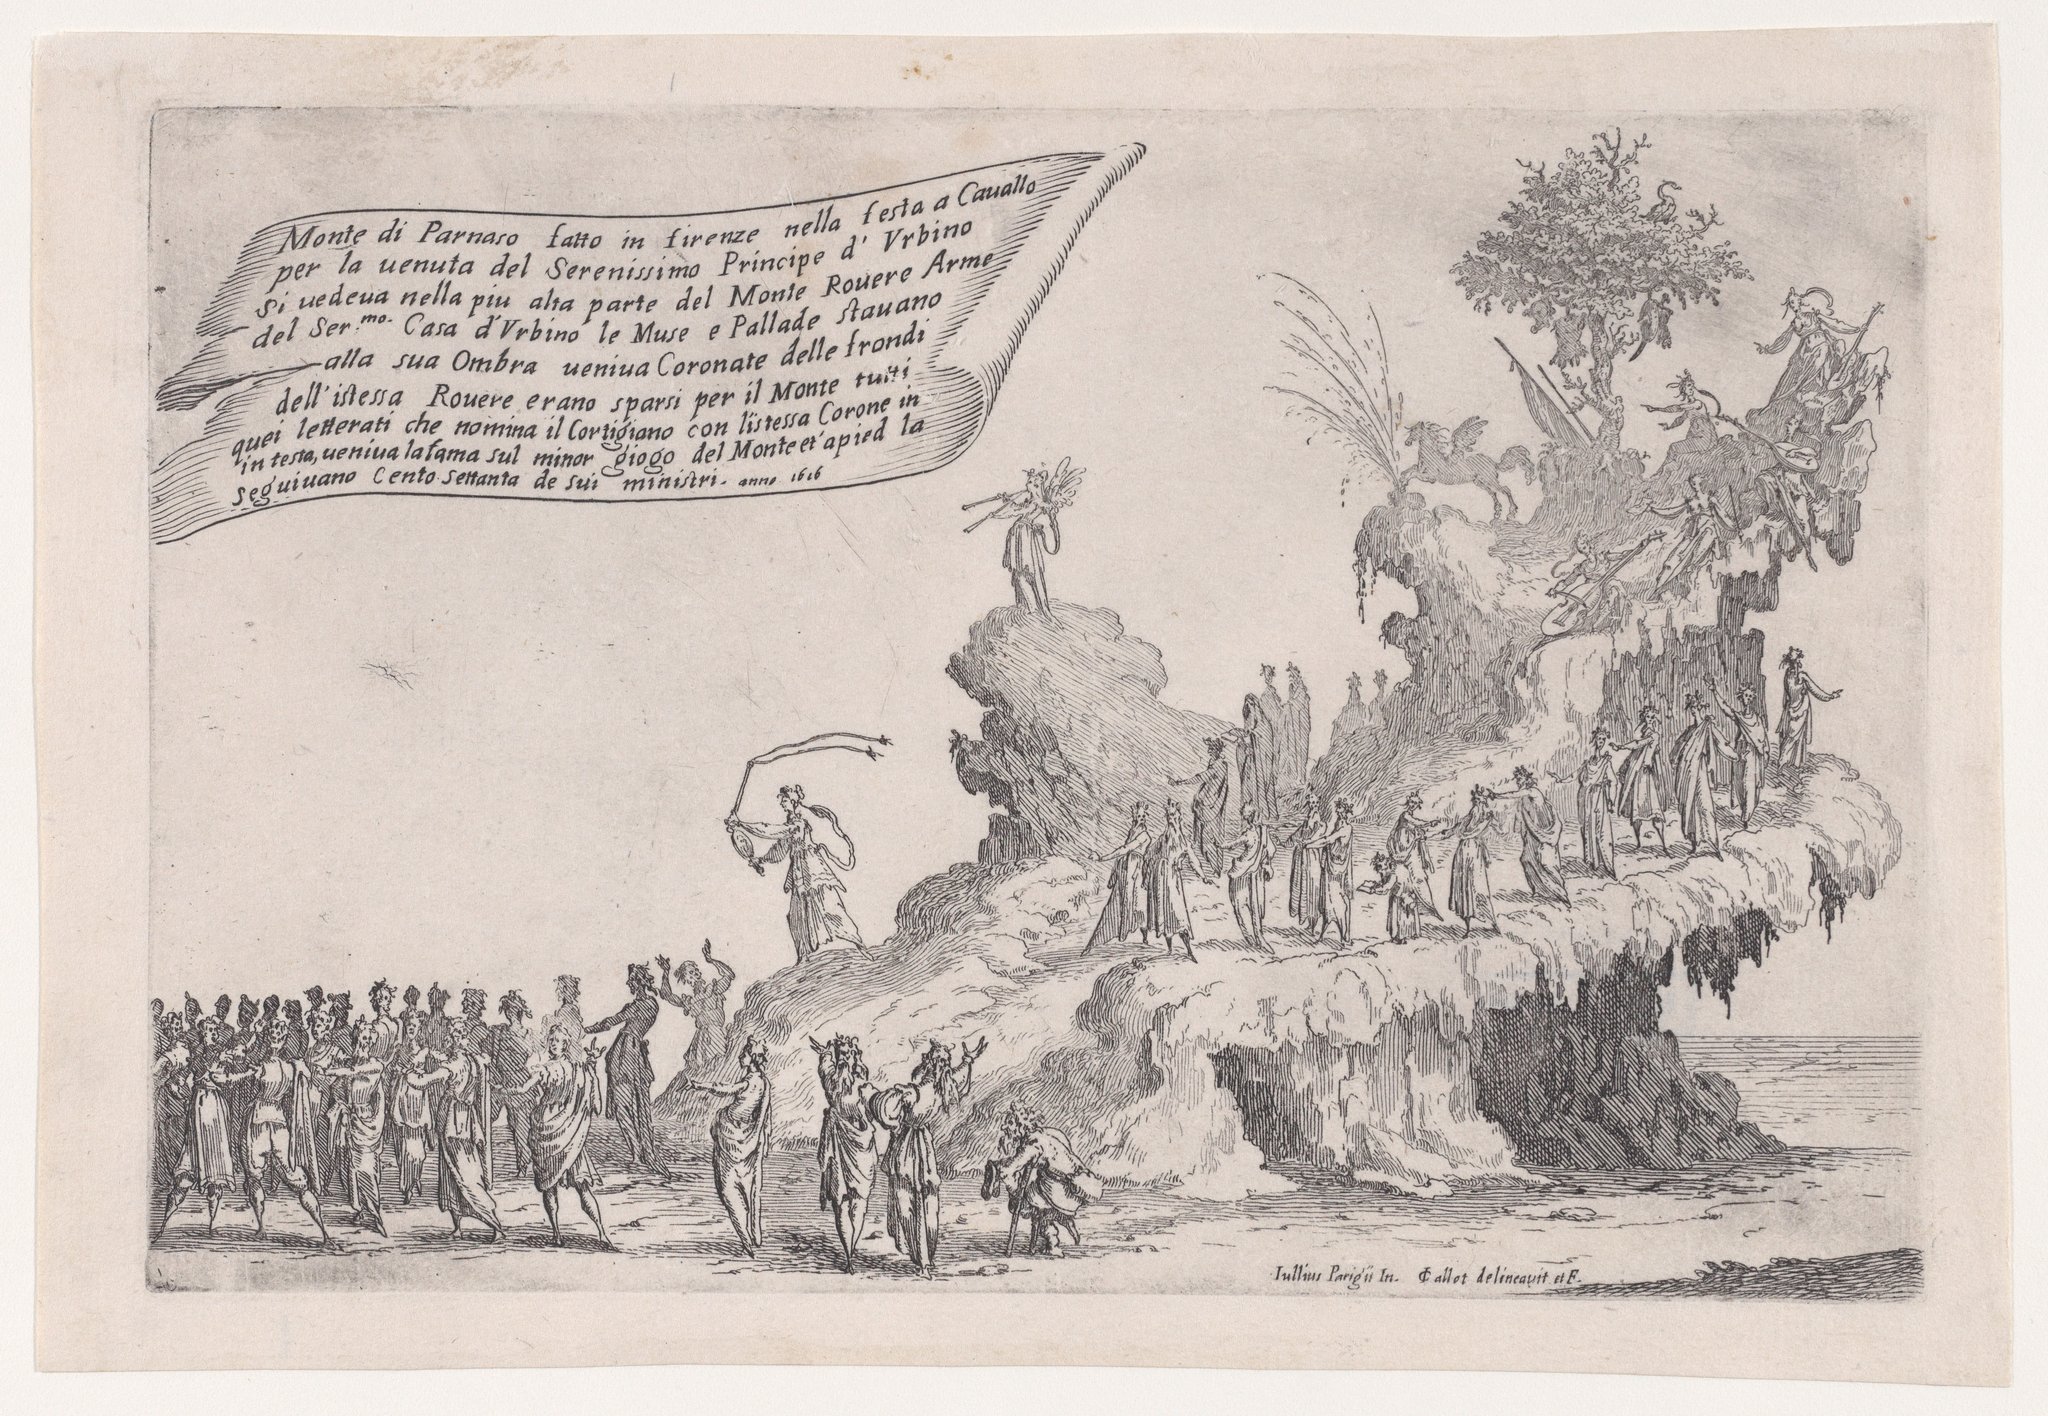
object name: print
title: Le Char du Mont Parnasse (The Chariot of Mount Parnassus), from "Guerre de Beauté" (Guerra di Bellezza) (War of Beauty)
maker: jacques callot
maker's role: artist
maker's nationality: french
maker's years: 1592-1635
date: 1616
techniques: etching